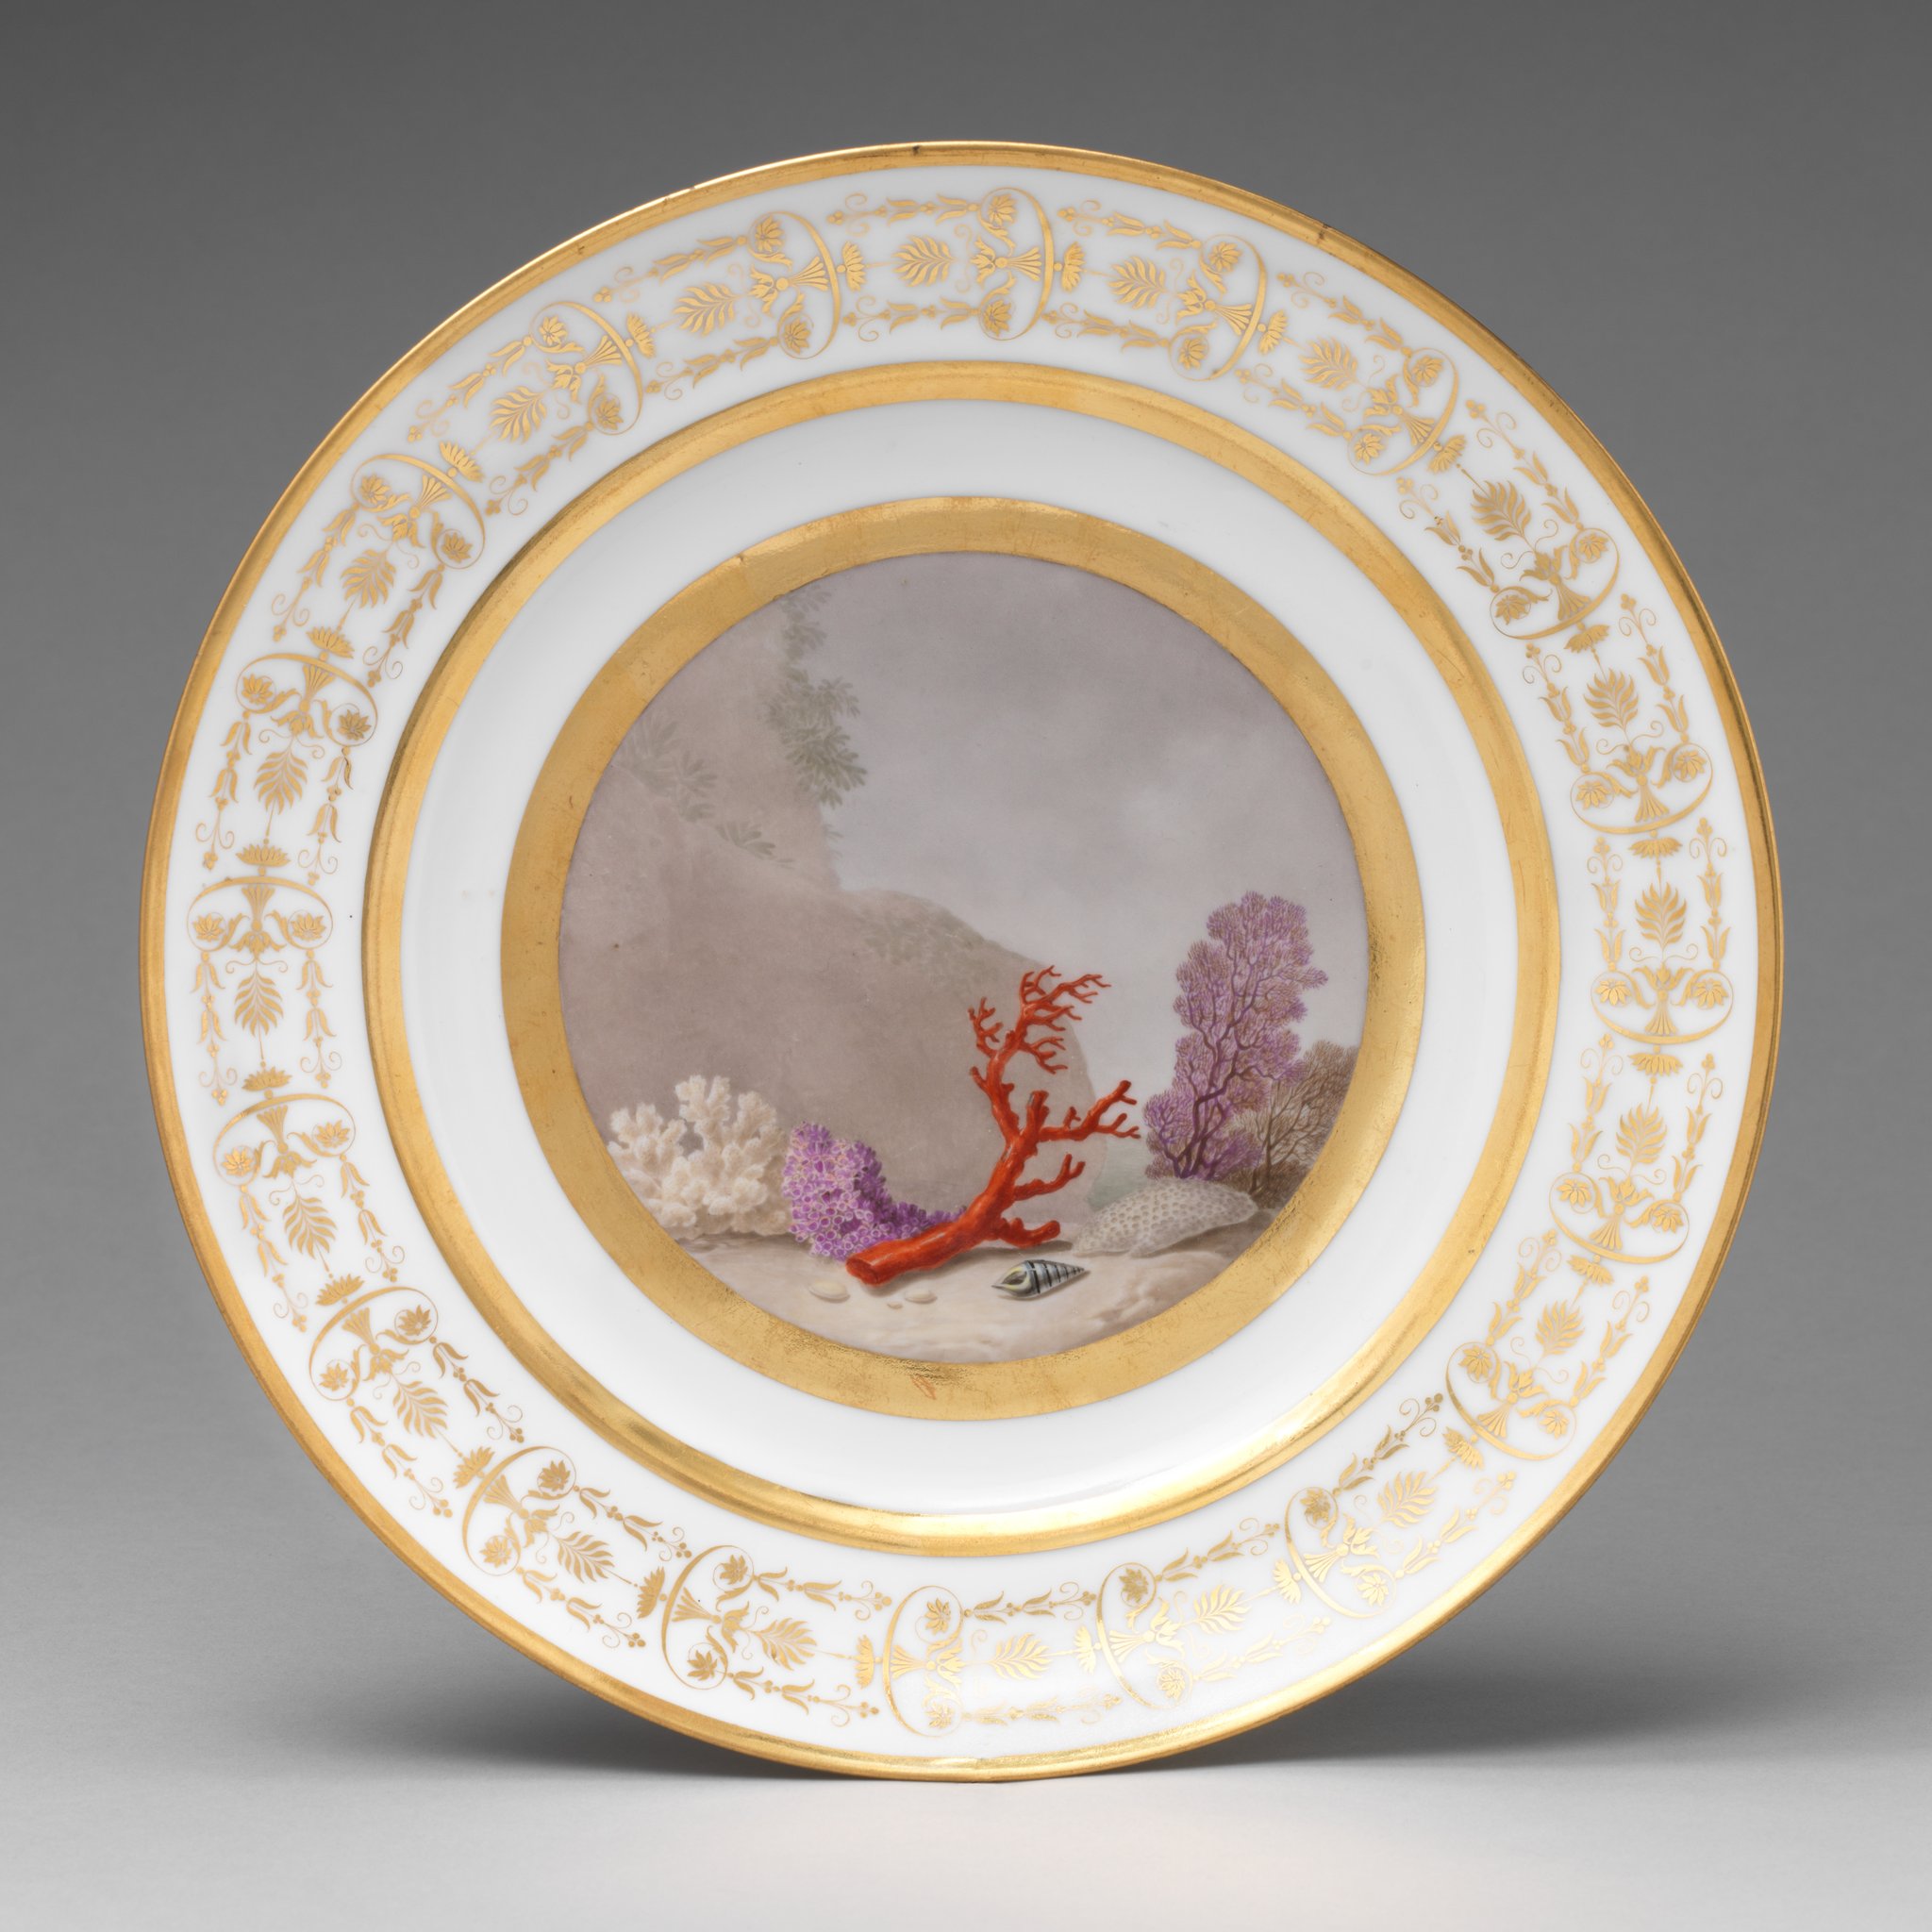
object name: plate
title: Plate with marine subject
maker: dihl et guérhard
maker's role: maker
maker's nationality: french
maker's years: 1781-1824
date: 1789-1797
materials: porcelain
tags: coral